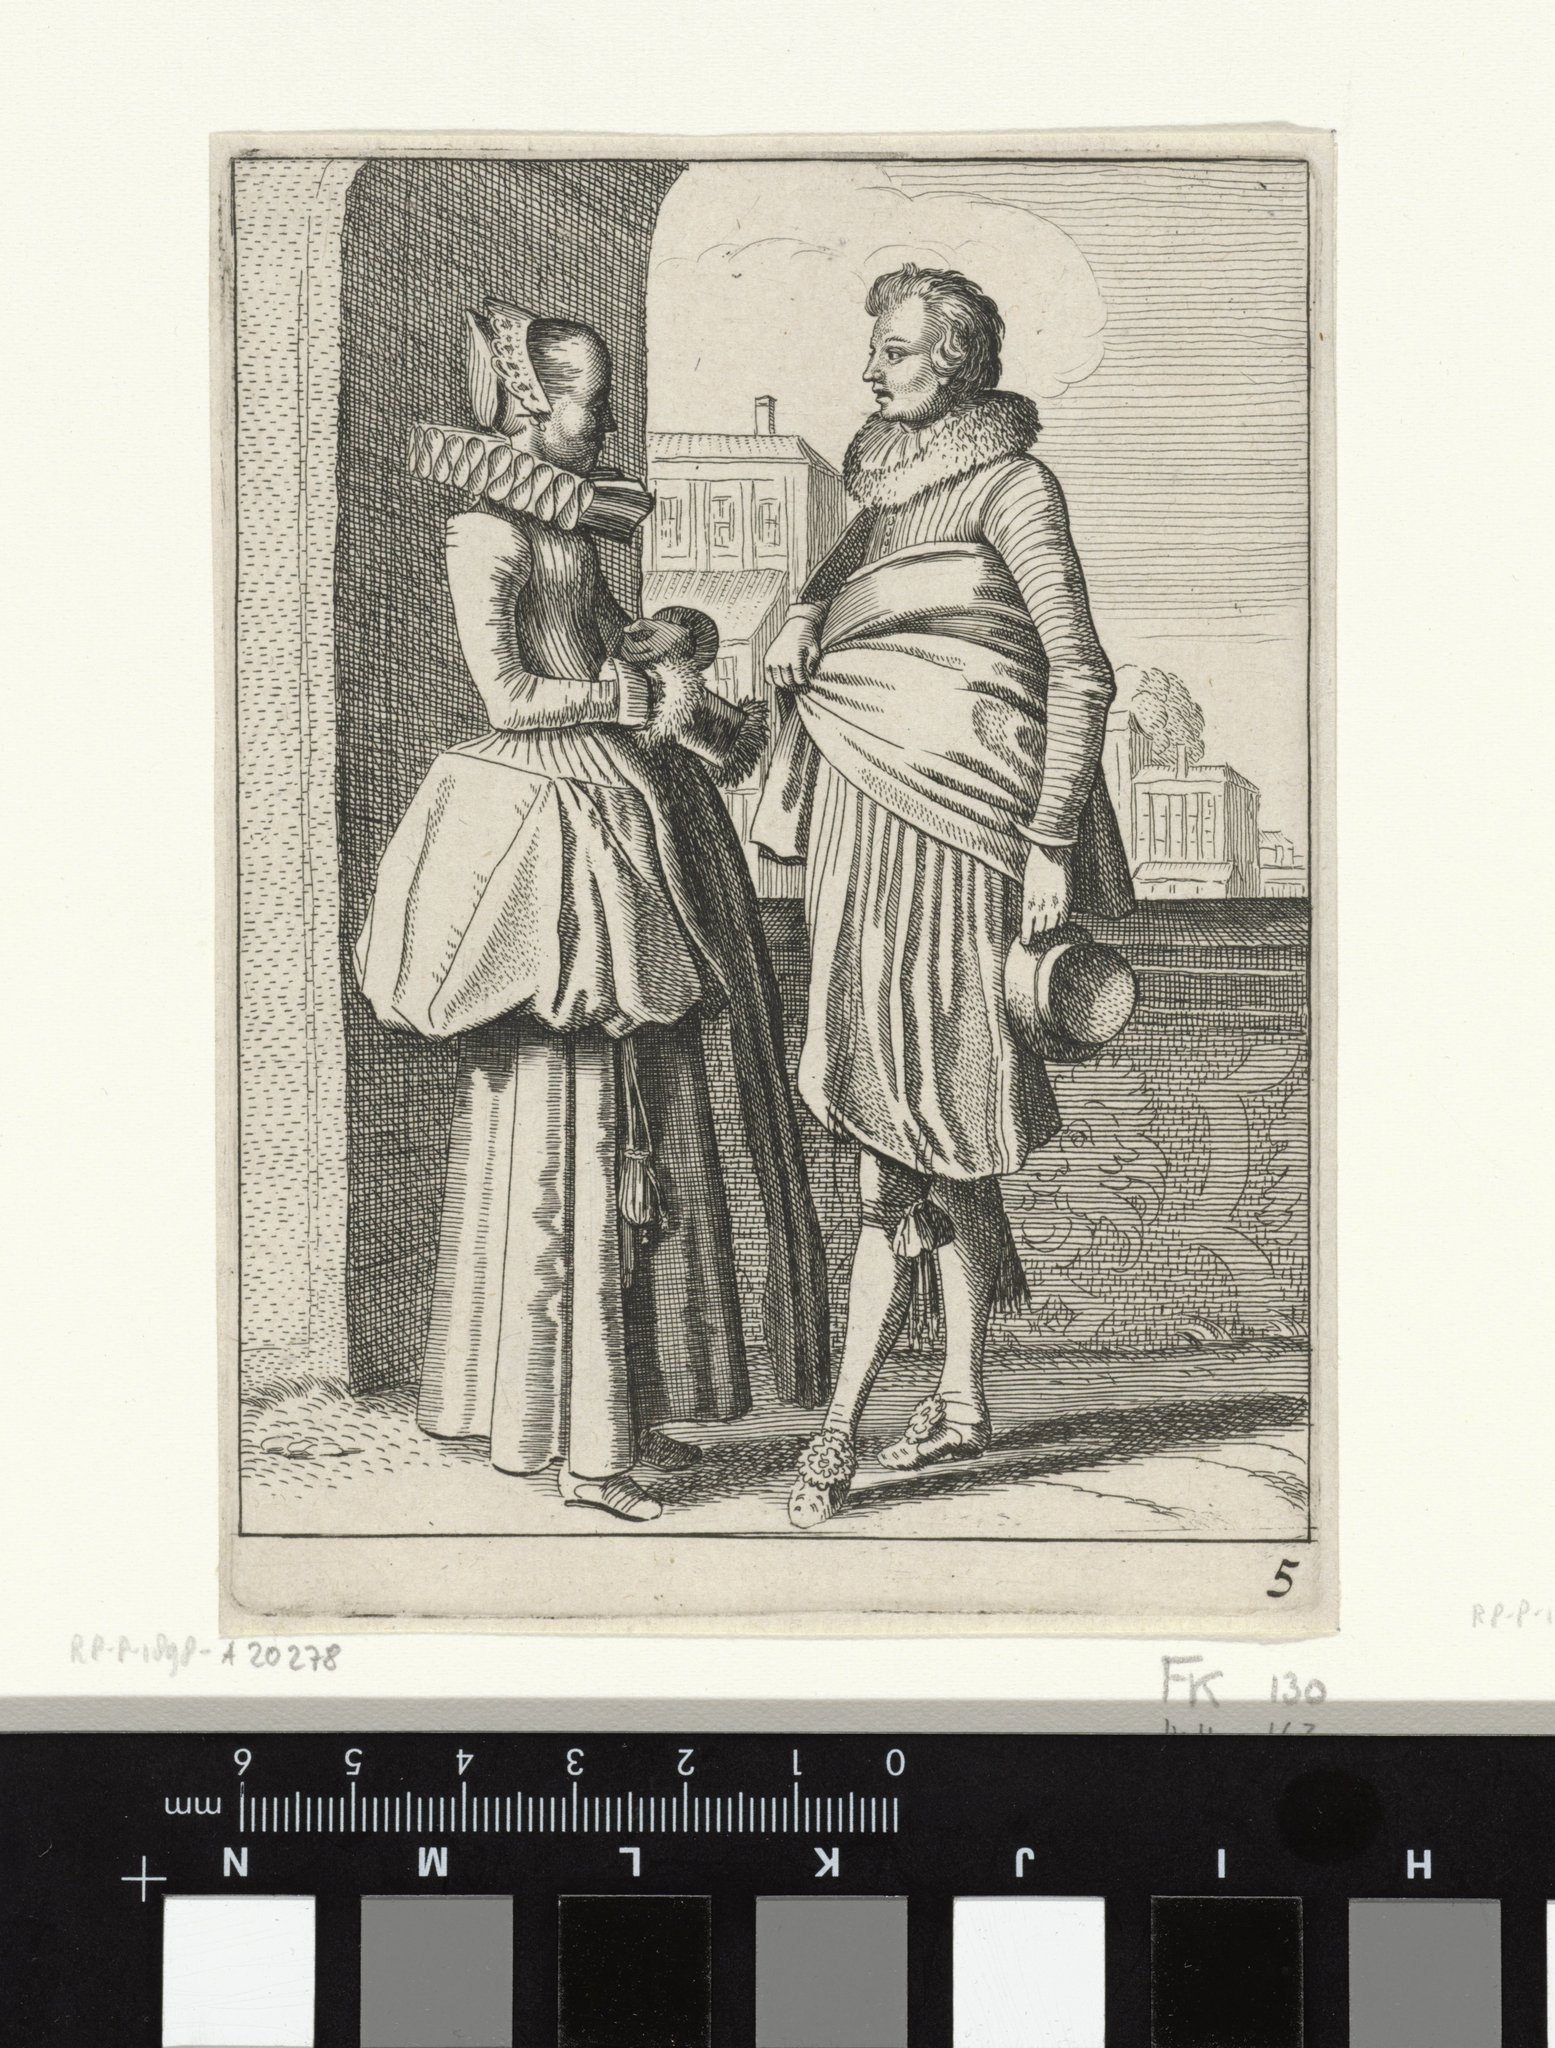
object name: costume print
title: Kostuums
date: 1603-1652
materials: paper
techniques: engraving, etching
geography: amsterdam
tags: neck-gear ~ clothing (with name) (+ men's clothes), coat (+ men's clothes), head-gear: hat (+ men's clothes), head-gear: cap (+ women's clothes), clothes, costume (+ women's clothes), neck-gear ~ clothing (with name) (+ women's clothes), skirt (+ women's clothes), shoes, sandals (+ men's clothes), clothes, costume (+ men's clothes), trousers, breeches, etc. (breeches) (+ men's clothes), clothing for the upper part of the body (doublet) (+ men's clothes), stockings, socks (+ men's clothes), clothing for the upper part of the body (with name) (+ women's clothes), muff (+ women's clothes), netherlands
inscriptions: collector's mark: Lugt 964, number: ‘5’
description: Kleding man: vilthoed met platte bol in de linkerhand; ronde kraag samengesteld uit losse laagjes; zeer wijde pofbroek tot de knie, met kouseband net onder de knie. Lage schoenen met spleten en rozetten. Kleding vrouw: diadeemmuts; grof geplooide (molensteen) kraag met plat voorstuk; overkleed met losse mouw